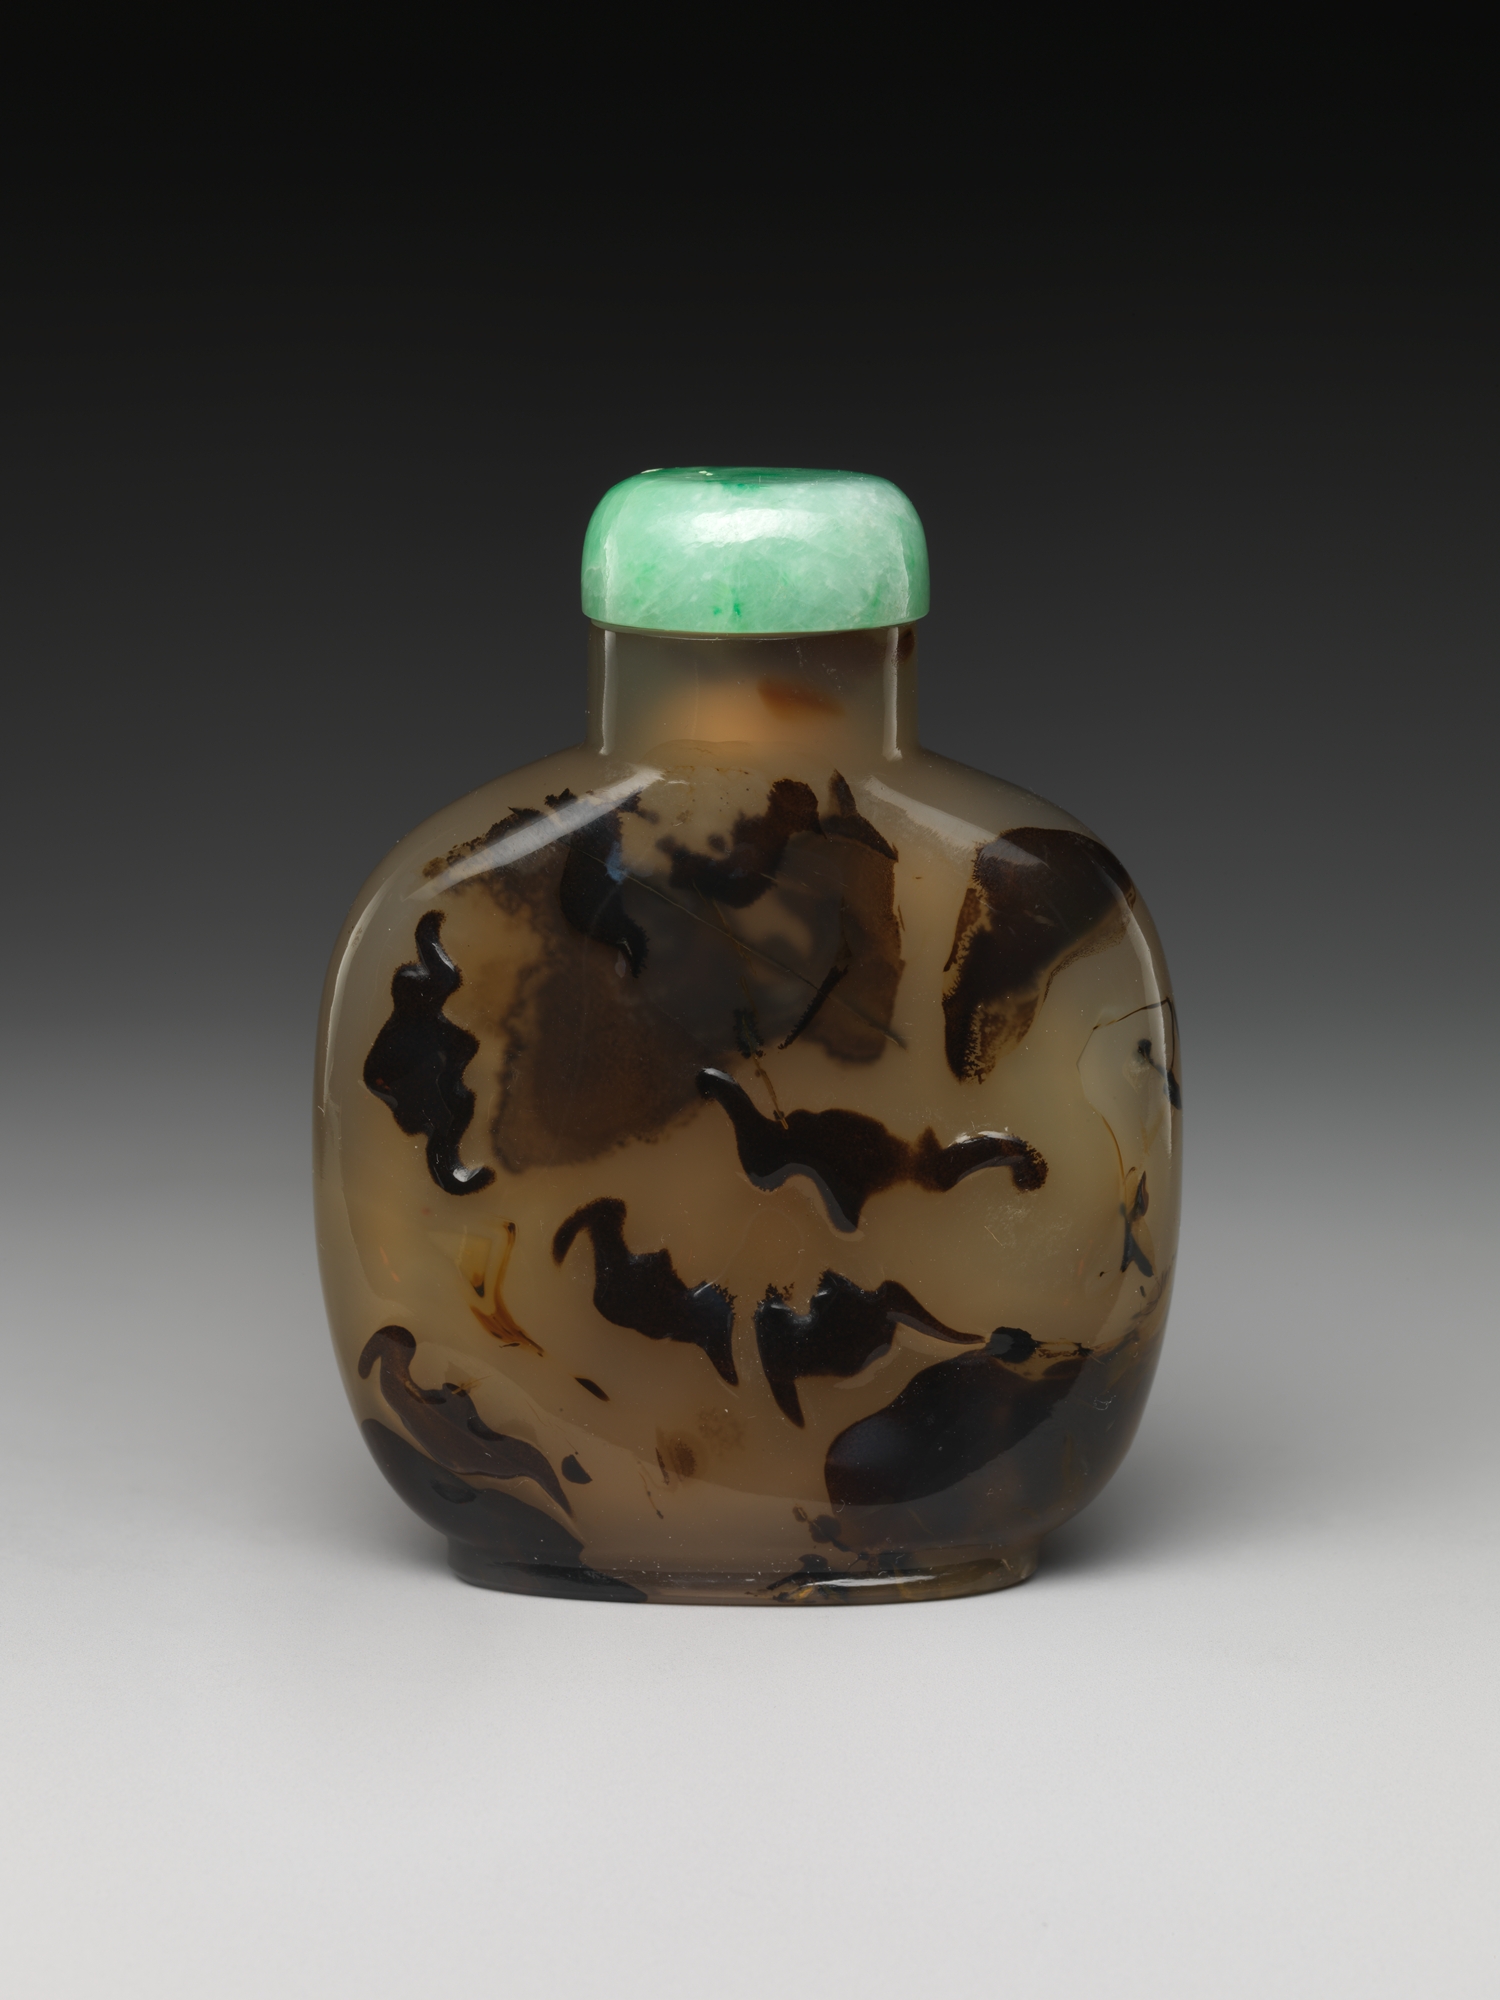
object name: snuff bottle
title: Snuff Bottle with Five Bats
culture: chinese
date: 1767-1800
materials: stone, jade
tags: bats